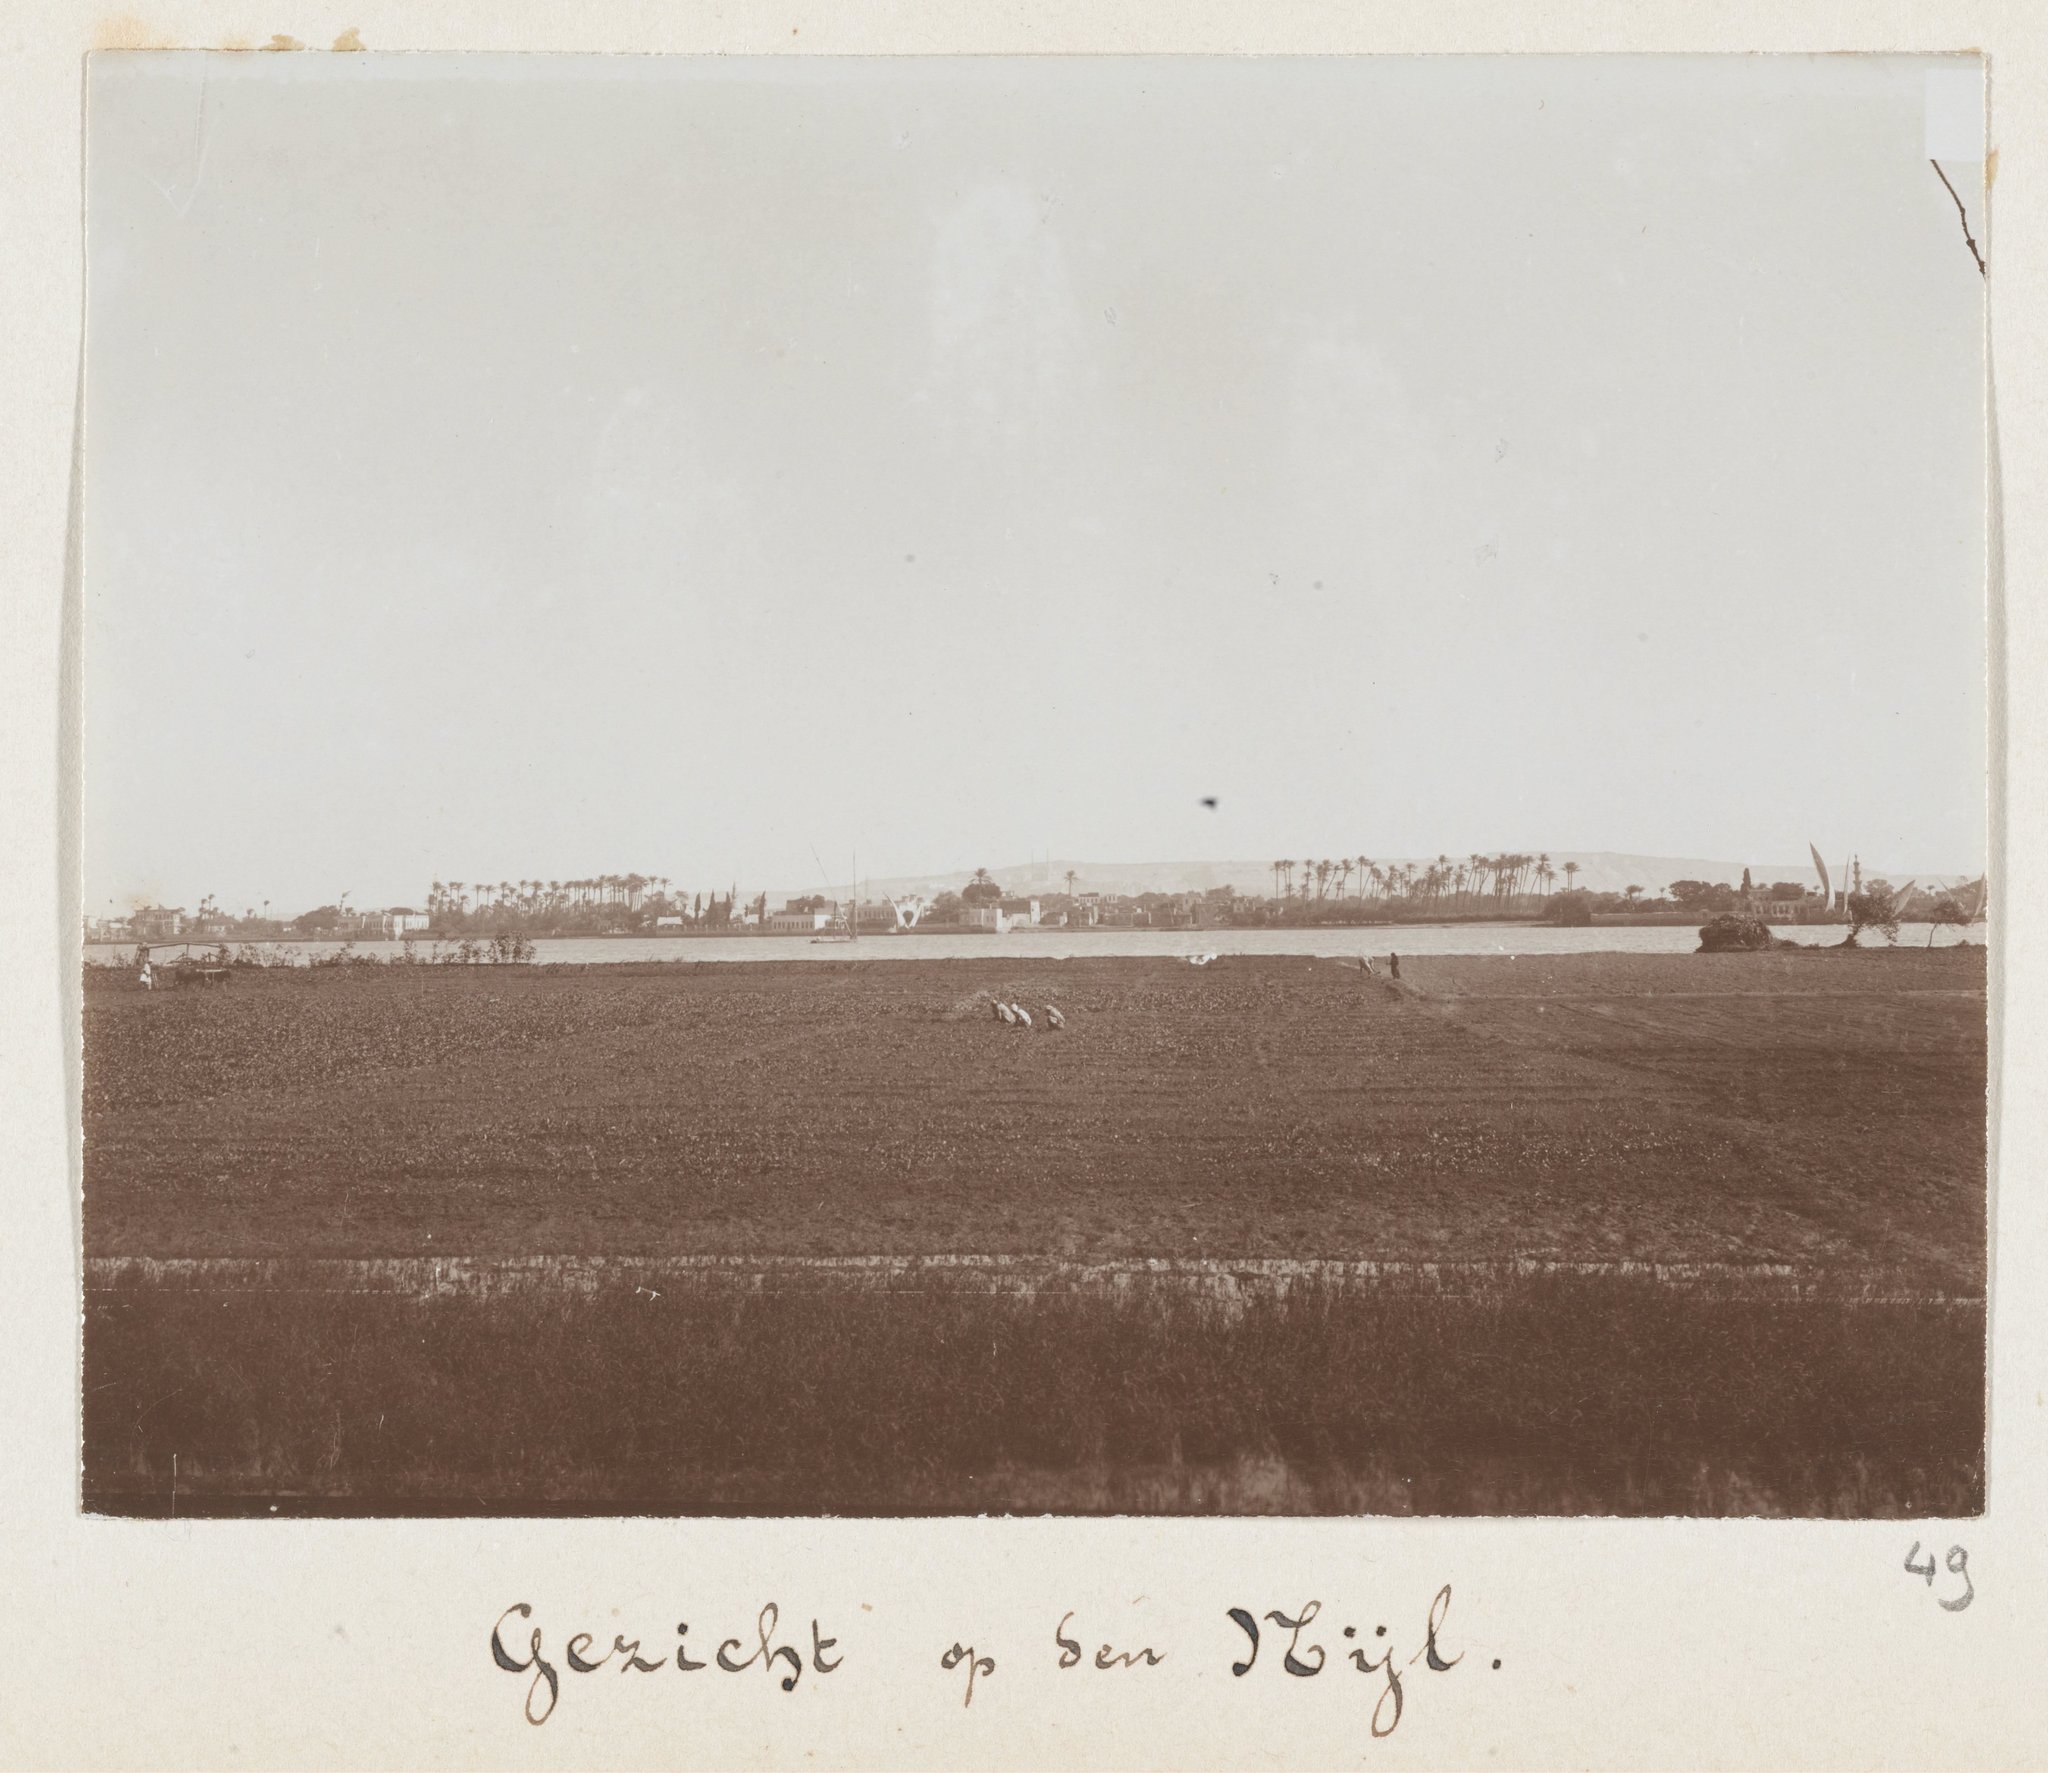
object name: photograph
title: Gezicht op de Nijl in Caïro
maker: johannes lodewijk heldring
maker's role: fotograaf, predikant, schrijver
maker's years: 1852-1923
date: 1898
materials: paper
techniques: collodion silver print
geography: cairo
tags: river